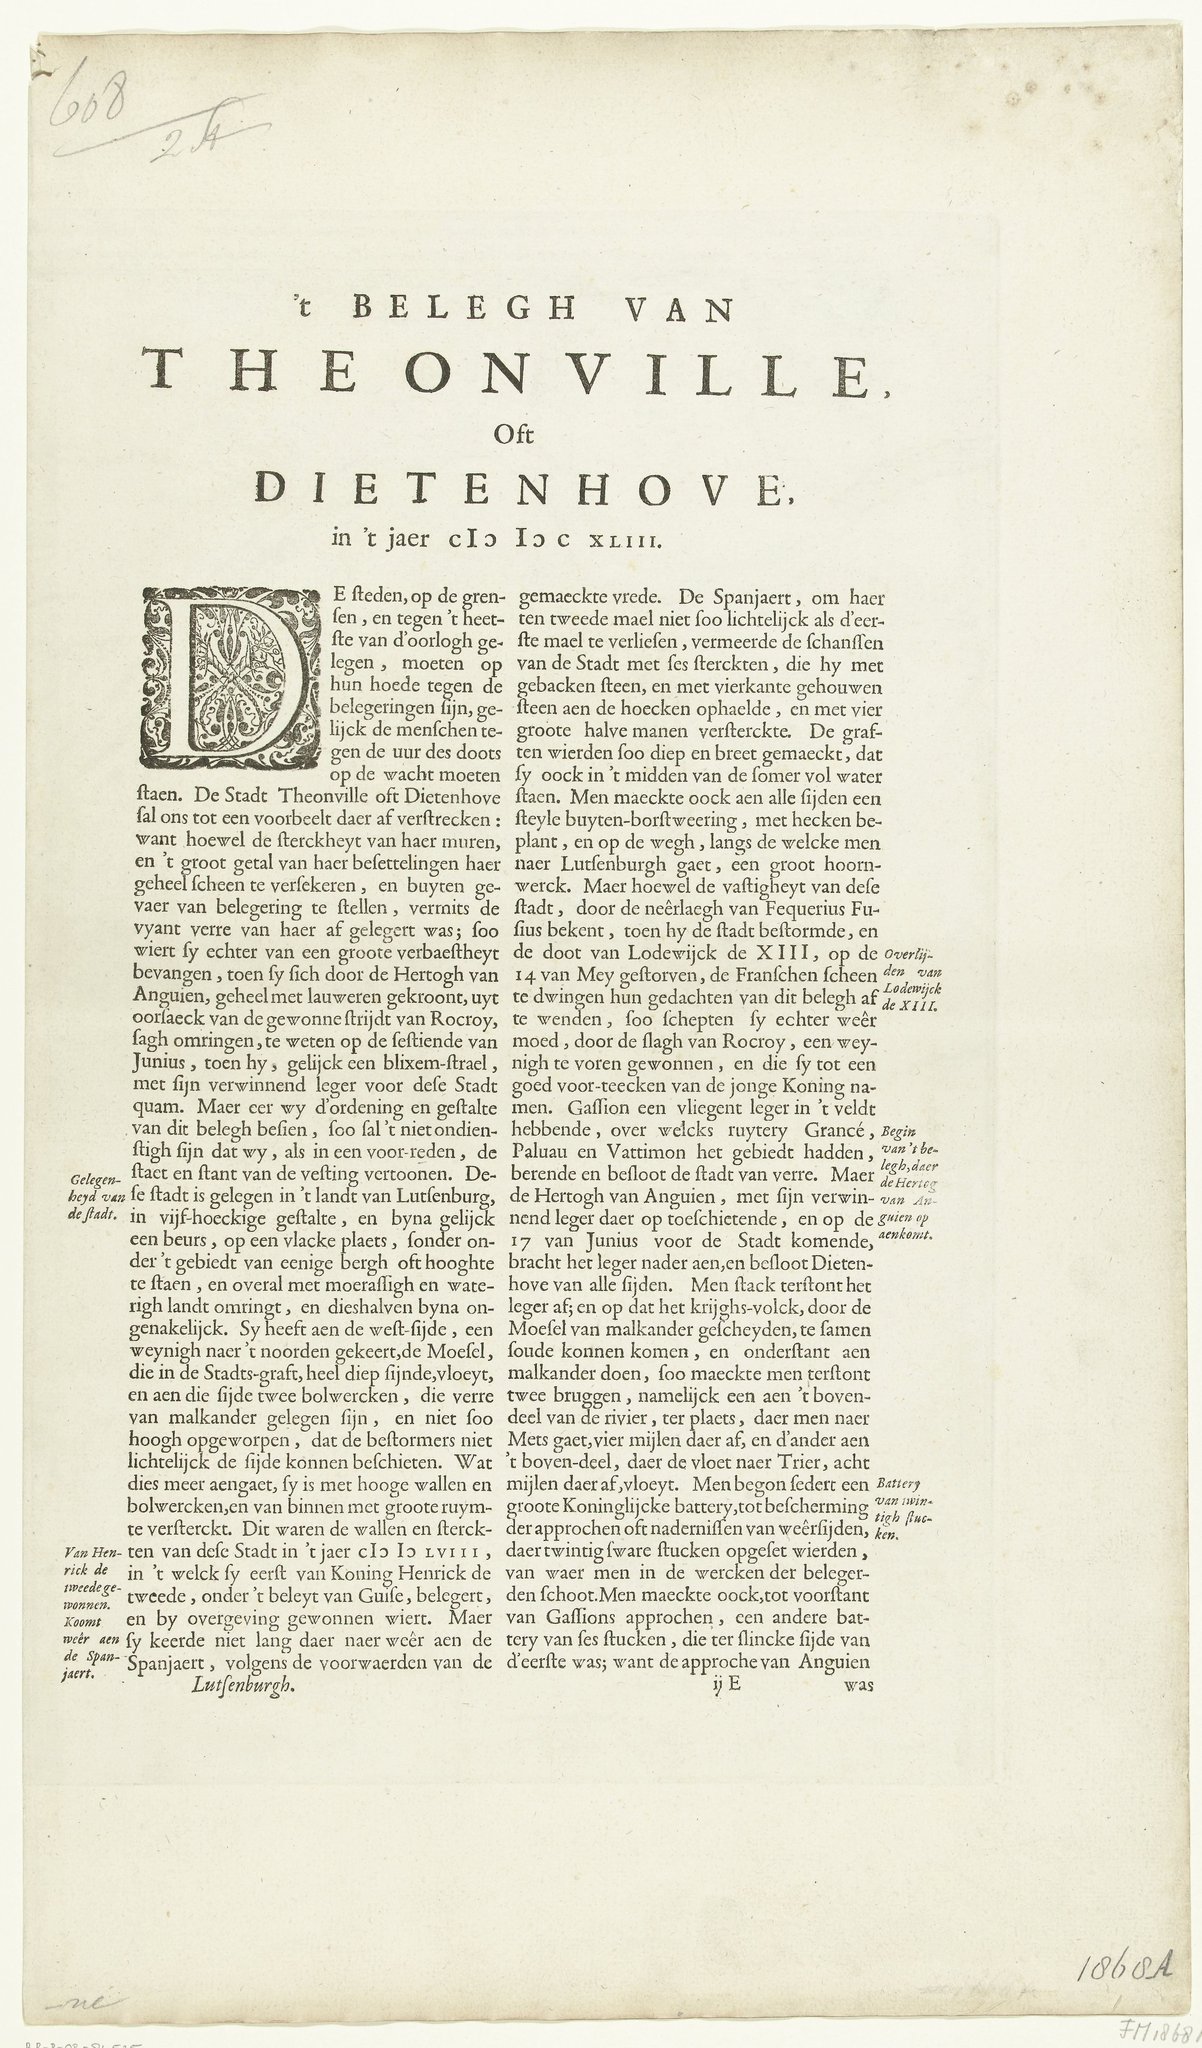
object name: history print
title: 't Belegh van Theonville, Oft Dietenhove, in 't jaer MDCXLIII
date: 1647-1649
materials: paper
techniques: etching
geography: amsterdam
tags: lodewijk xiv (koning van frankrijk), paris, lodewijk ii de bourbon-condé (hertog van enghien), maps of separate countries or regions, siege, position war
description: Kaart van de belegering van Thionville door het Franse leger onder Lodewijk II van Bourbon-Condé, de hertog van Enghien,18 juni - 10 augustus 1643. Linksonder een inzet met een detailkaartje van loopgraven bij de stad, rechtsonder de legenda op de cijfers in de Franse legerkampen. Op een dubbelblad genomen uit het Stedenboek van Blaeu. Bedrukt op de achterzijde met tekst in het Nederlands.